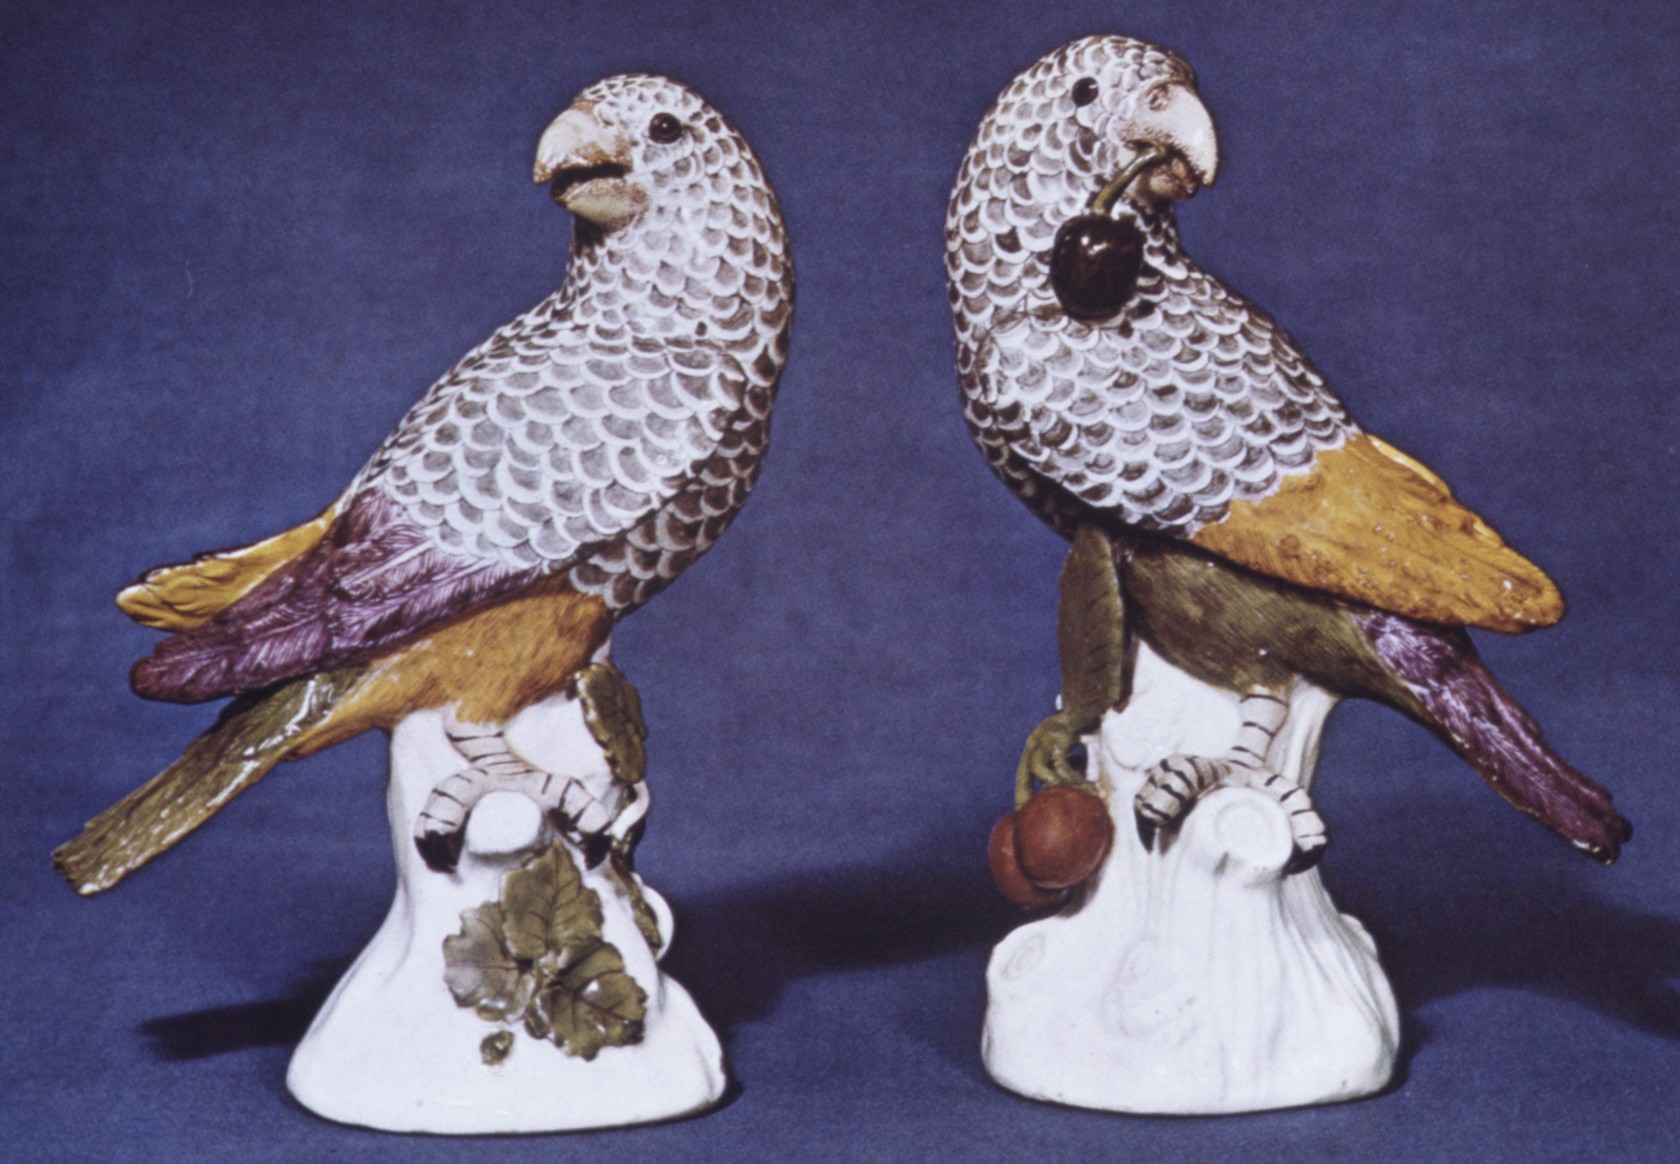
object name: figure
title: Parrot (one of a pair)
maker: meissen manufactory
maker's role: manufactory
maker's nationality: german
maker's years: 1710-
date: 1740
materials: hard paste porcelain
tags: parrots